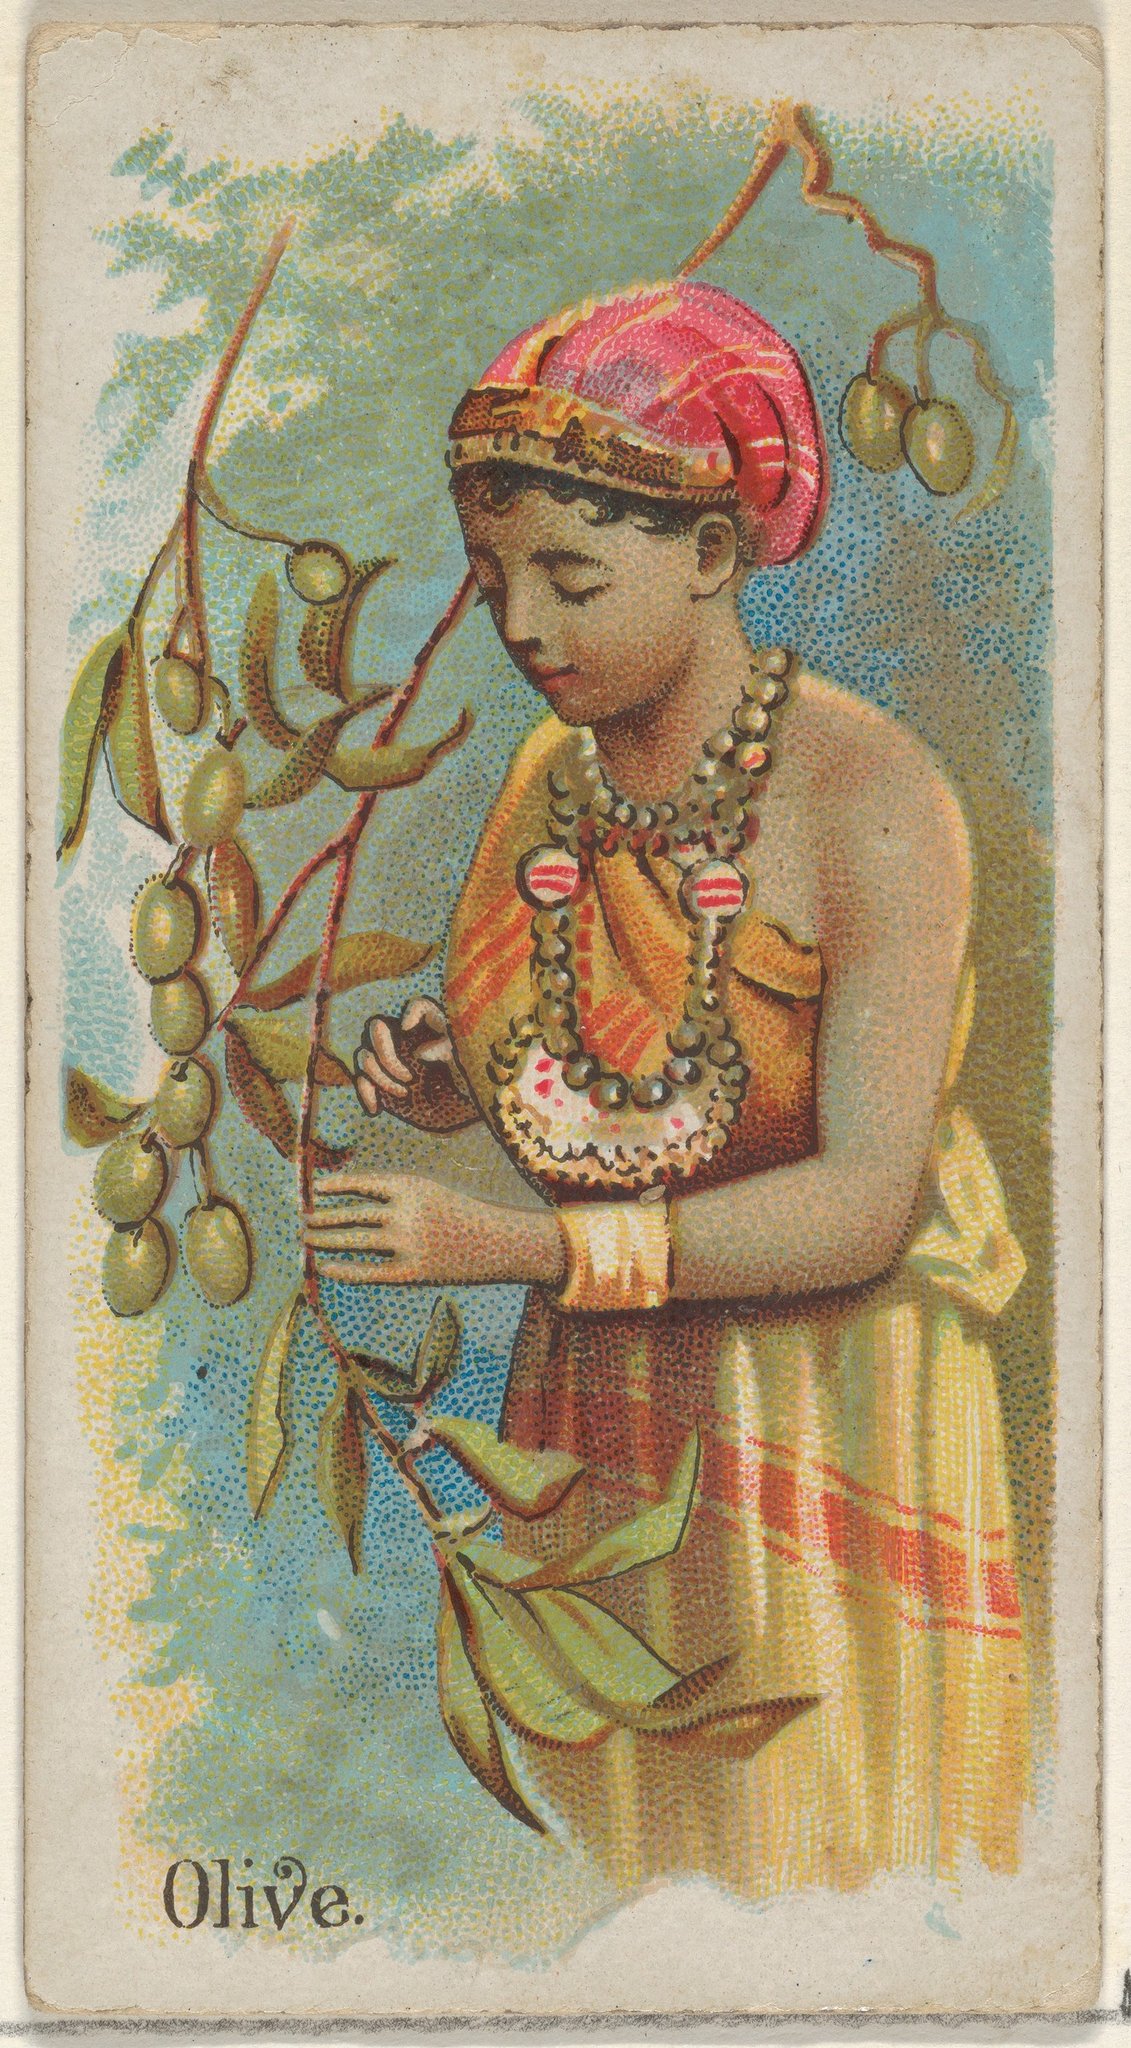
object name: print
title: Olive, from the Fruits series (N12) for Allen & Ginter Cigarettes Brands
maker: allen & ginter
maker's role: publisher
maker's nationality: american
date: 1891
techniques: color lithograph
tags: women,olive trees